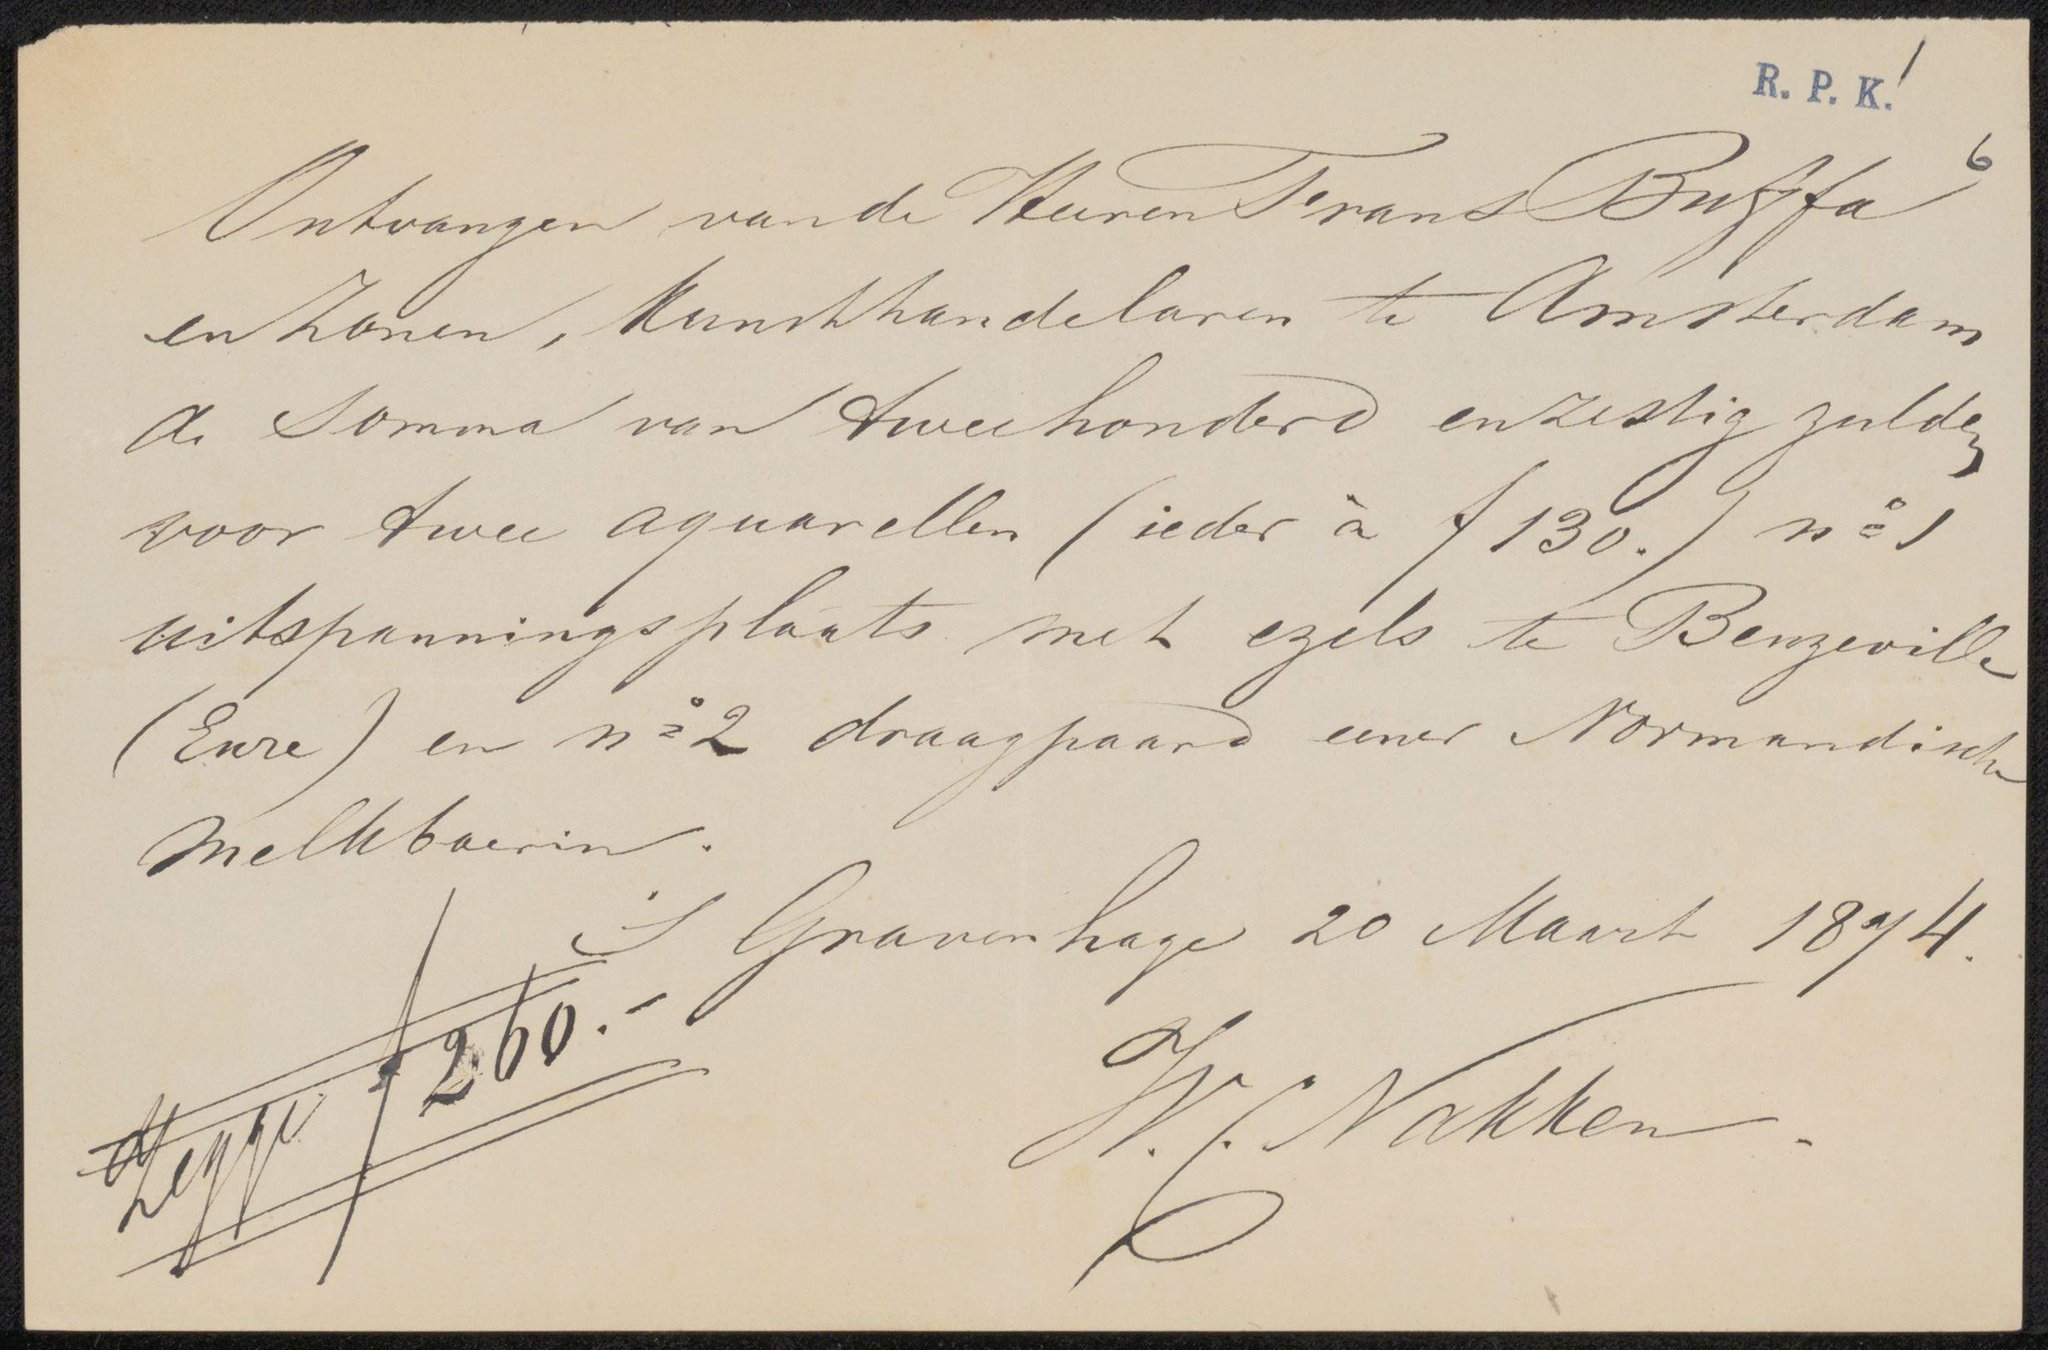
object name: ontvangstbewijs, kwitantie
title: Kwitantie voor Frans Buffa en Zonen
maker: willem carel nakken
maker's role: draughtsman, painter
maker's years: 1835-1926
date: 1874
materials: ink, paper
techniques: pen, writing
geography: the hague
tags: publisher, drawing, money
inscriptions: collector's mark: Lugt 2233